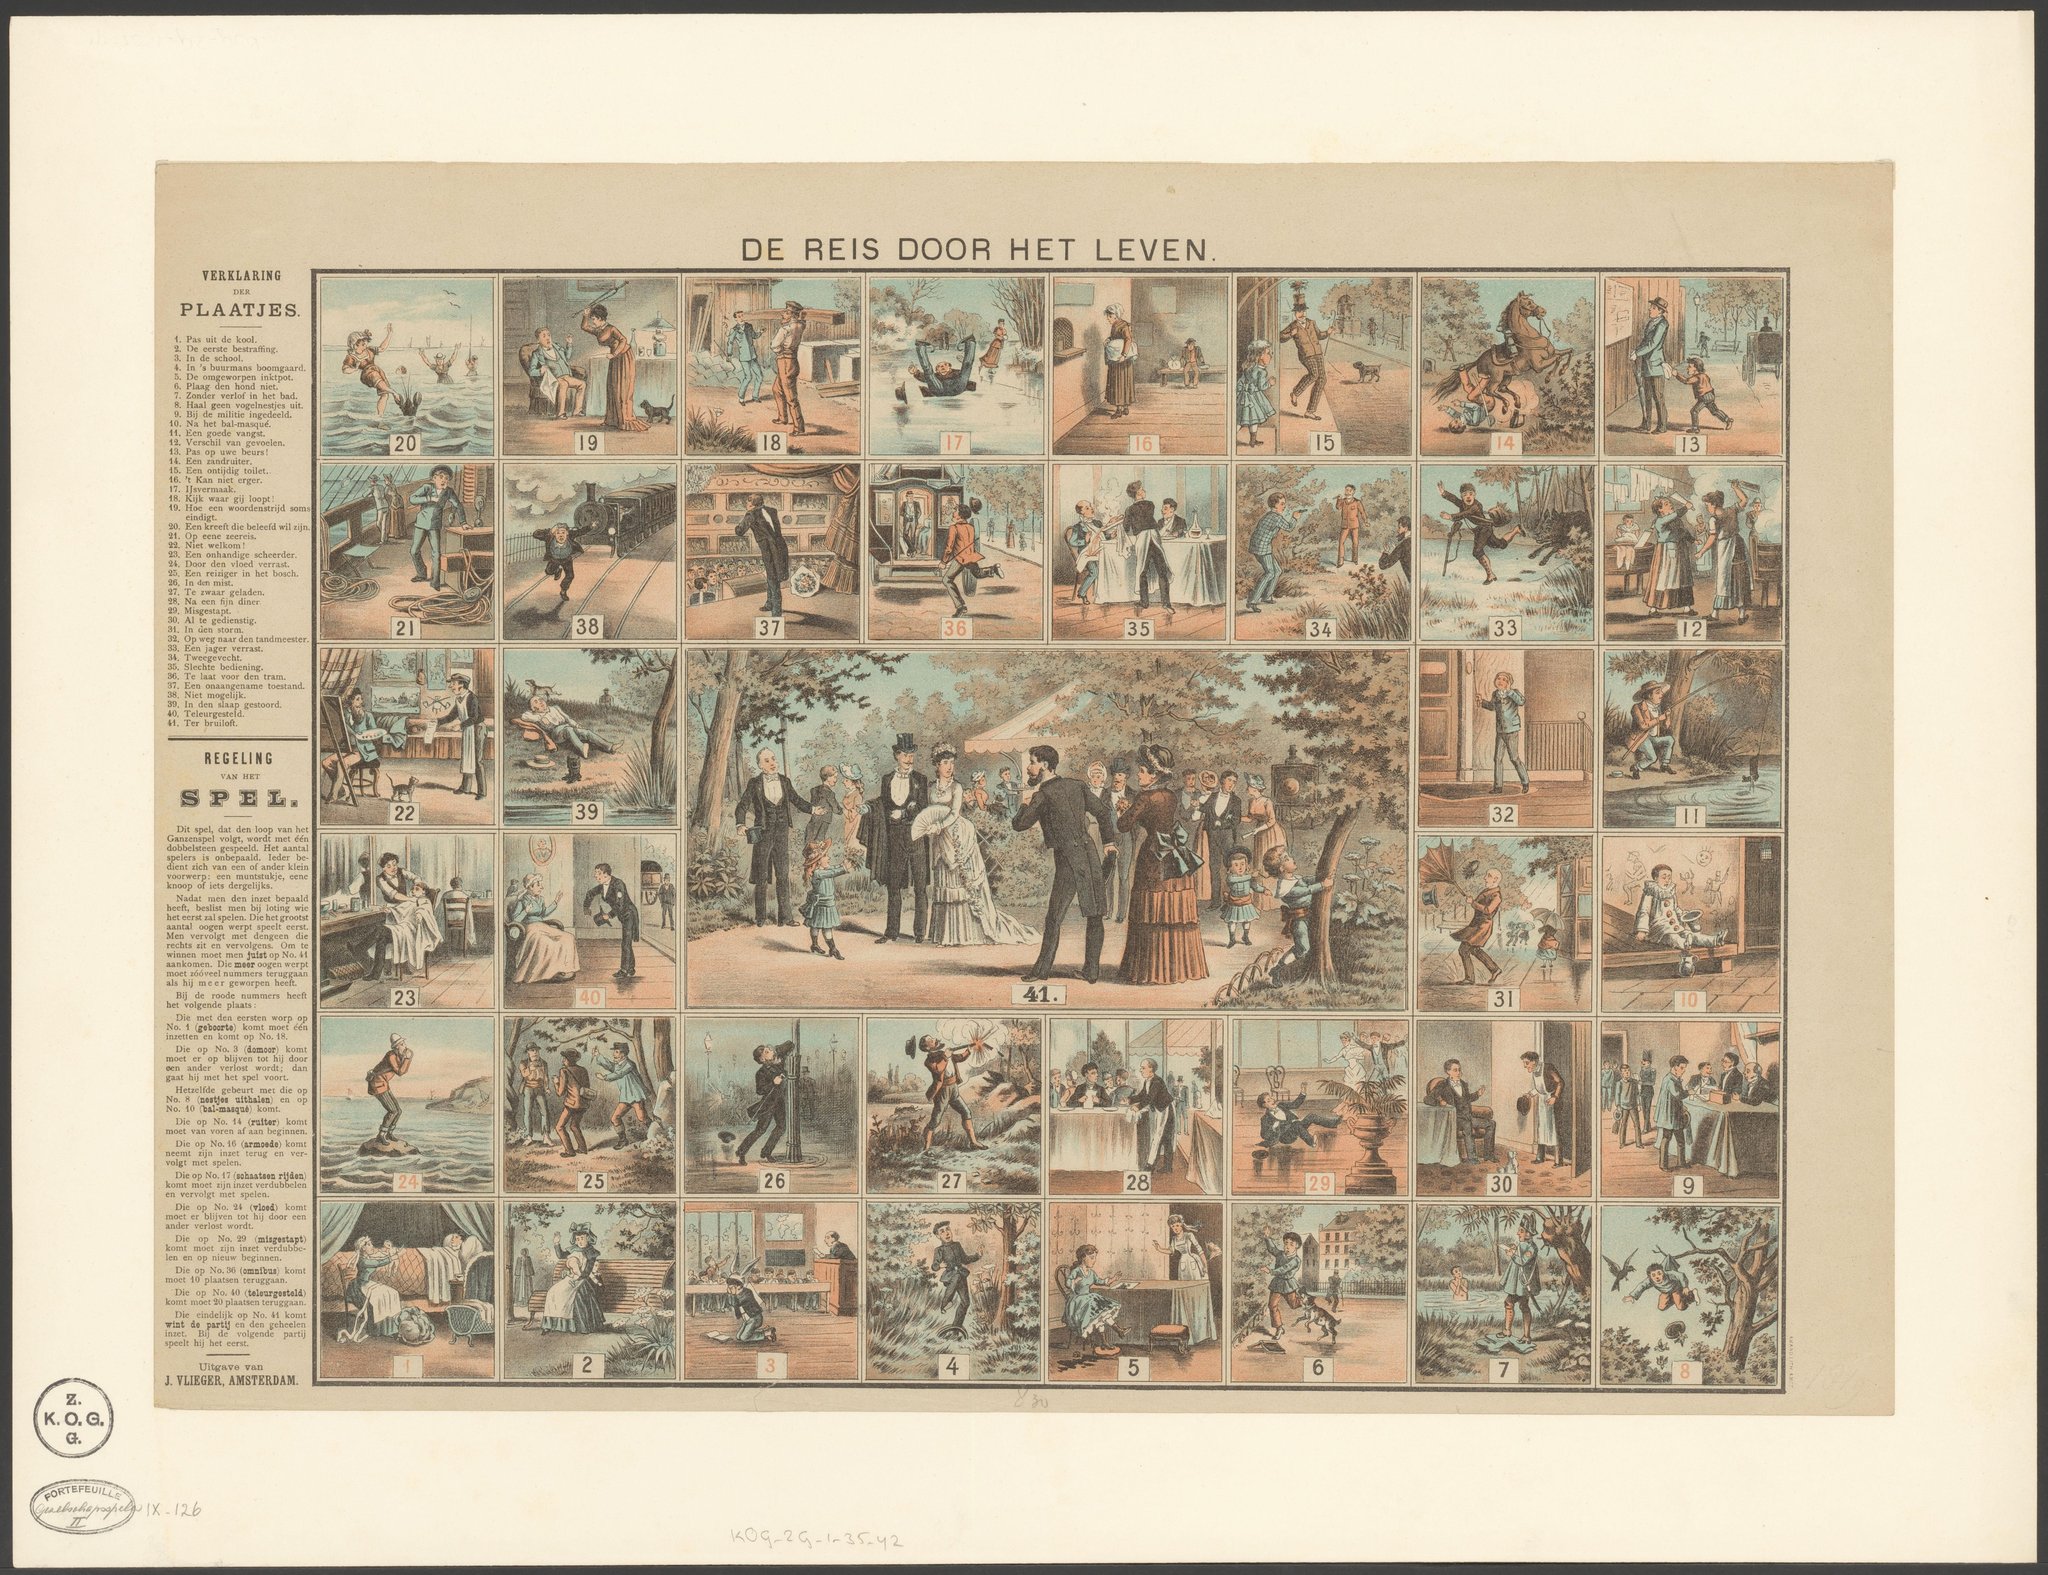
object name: gameboard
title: De reis door het leven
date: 1869-1908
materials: textile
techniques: lithograph, letterpress printing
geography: amsterdam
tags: board-games of chance, board-games, human life divided into stages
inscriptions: stamp, collector's mark: Lugt 1641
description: Rechthoekig bordspel met vakken genummerd van 1 tot en met 41, lopend in een spiraal. In de vakken voorstellingen van verschillende fasen uit het leven van de mens, van geboorte tot bruiloft. Linksboven verklaring van de platen, linksonder de spelregels en bovenaan de titel. Onderwerpsrubrieken binnen de Atlas Zeden en Gewoonten: Zeden en gewoonten in engeren zin, Spel en vermaak, Gezelschapsspel II, Ganzenbord en dergelijke.